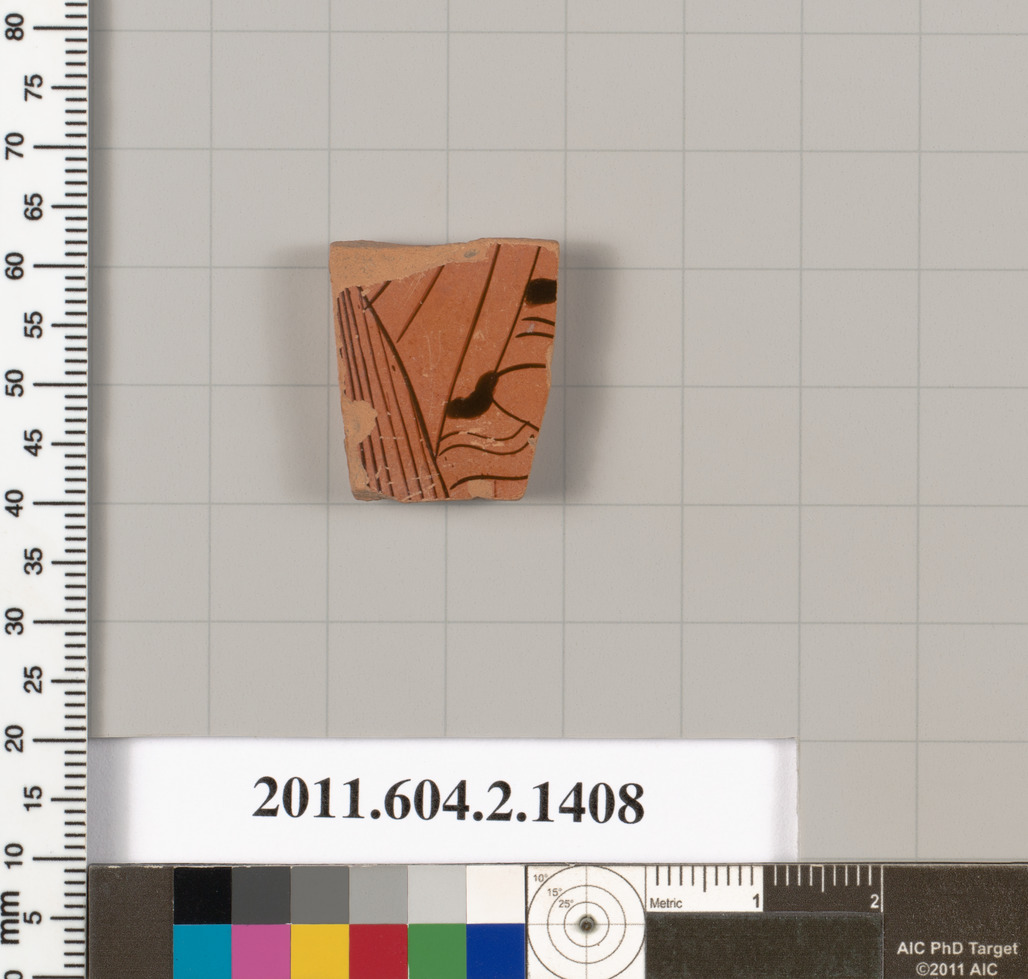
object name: skyphos fragment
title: Terracotta fragment of a skyphos (deep drinking cup)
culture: greek, attic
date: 475-451 BCE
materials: terracotta